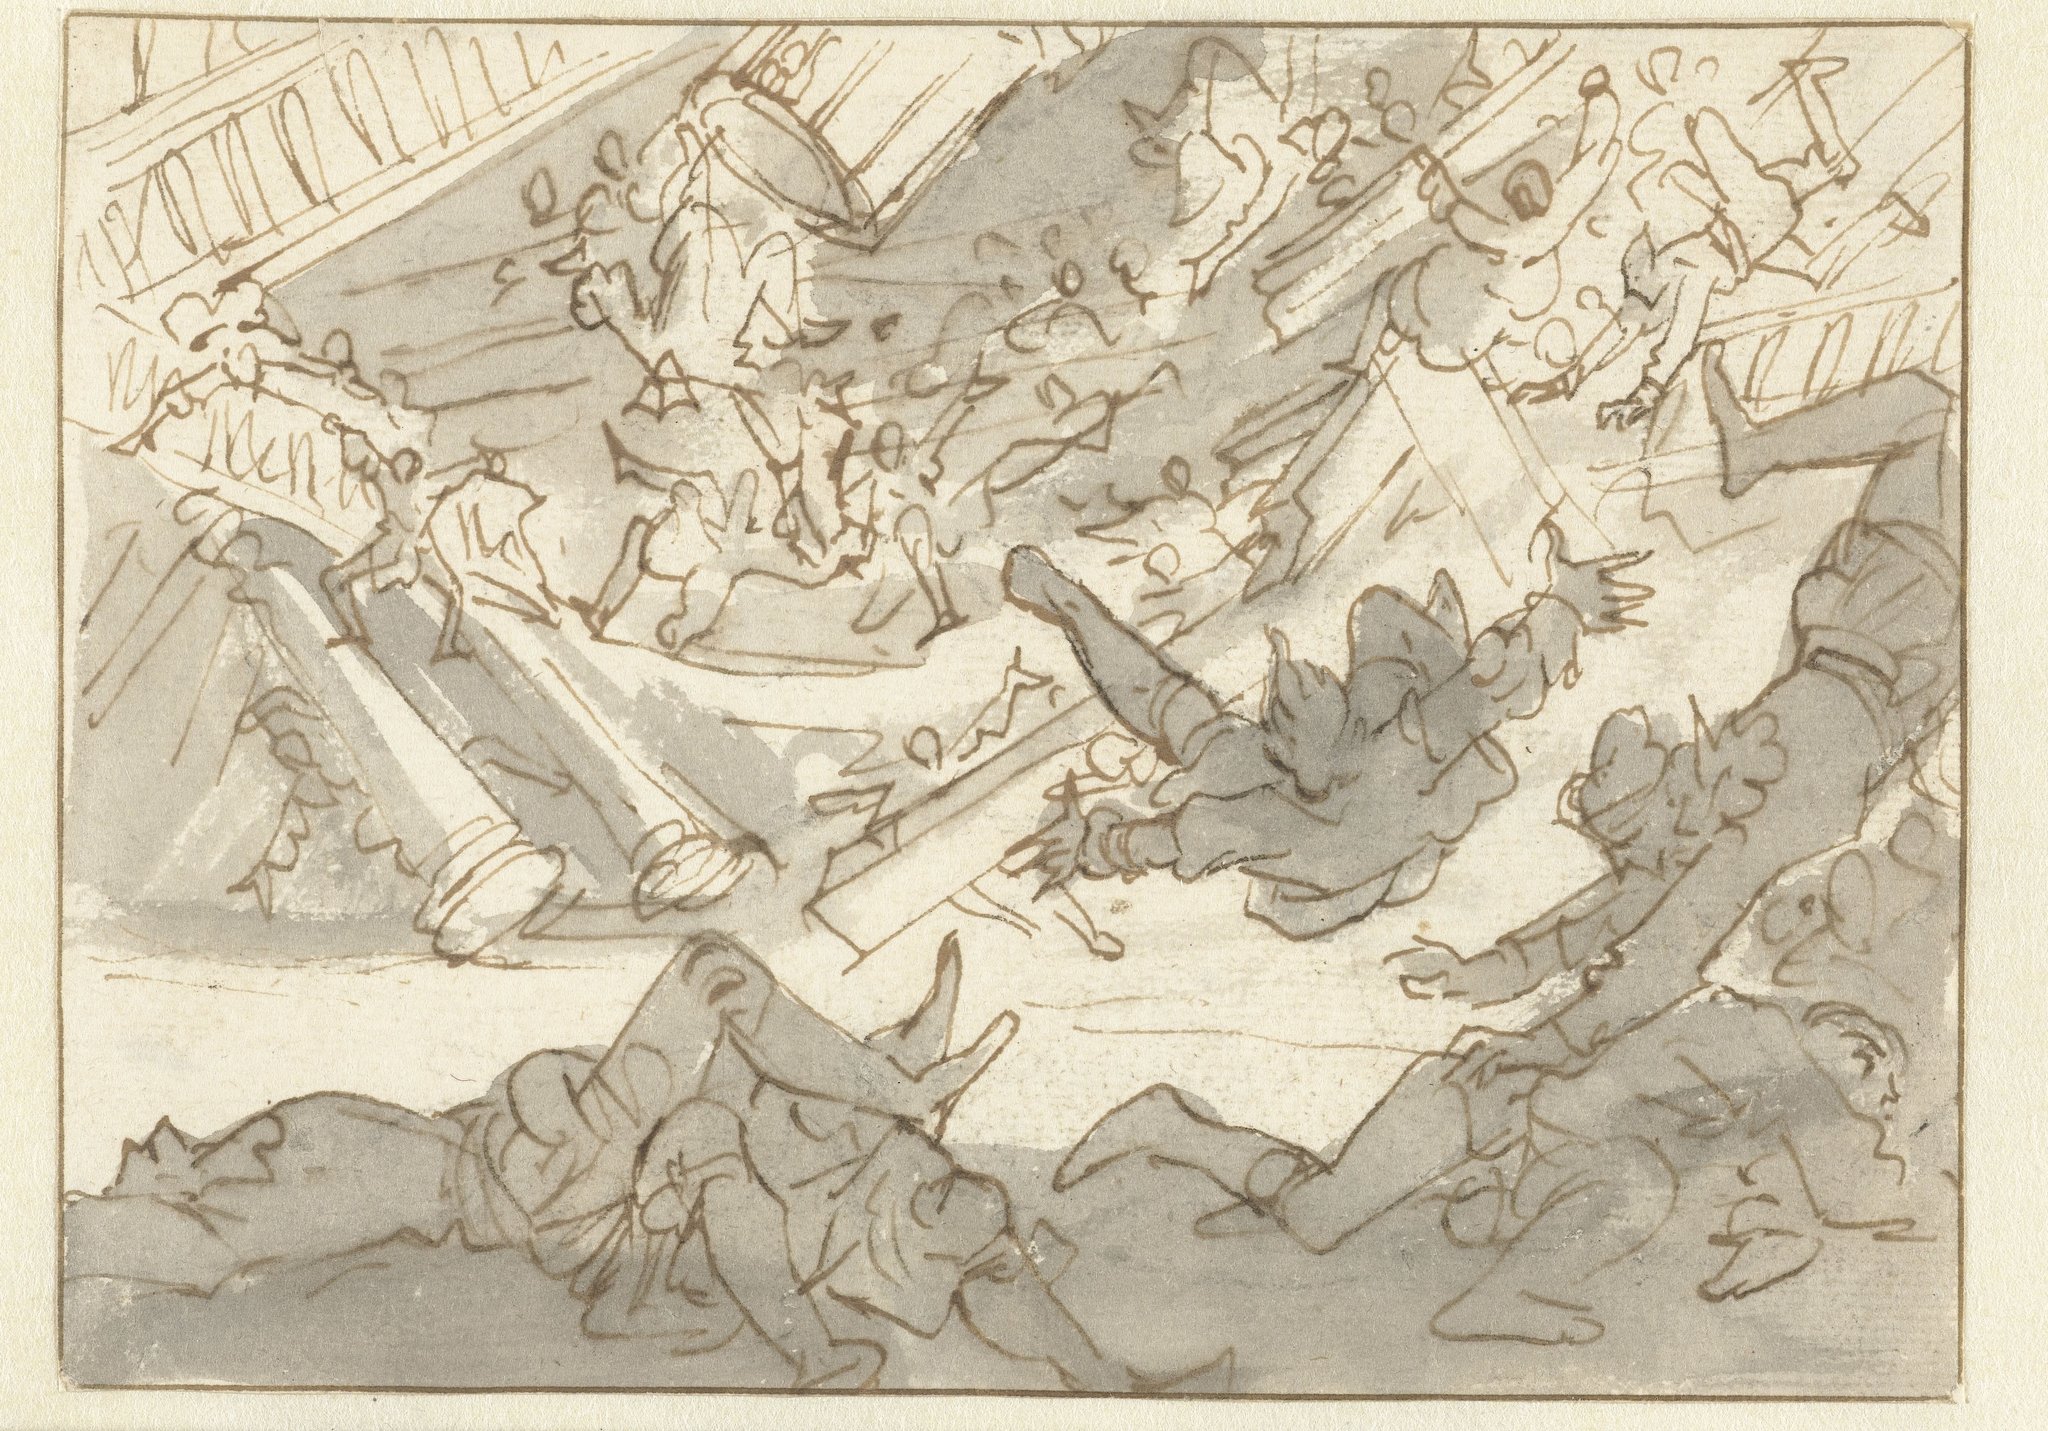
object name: drawing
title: Ineenstorting van het huis van een Spaanse gezant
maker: caspar luyken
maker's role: draughtsman, print maker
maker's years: 1672-1708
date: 1696-1698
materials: ink, paper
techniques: brush, pen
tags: holy mass (divine service, especially of roman catholic church), collapsing building, accidental death by falling objects, historical events and situations, london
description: Ineenstorting van het huis van een Spaanse gezant te Londen tijdens een katholieke mis. Ontwerp voor een prent.